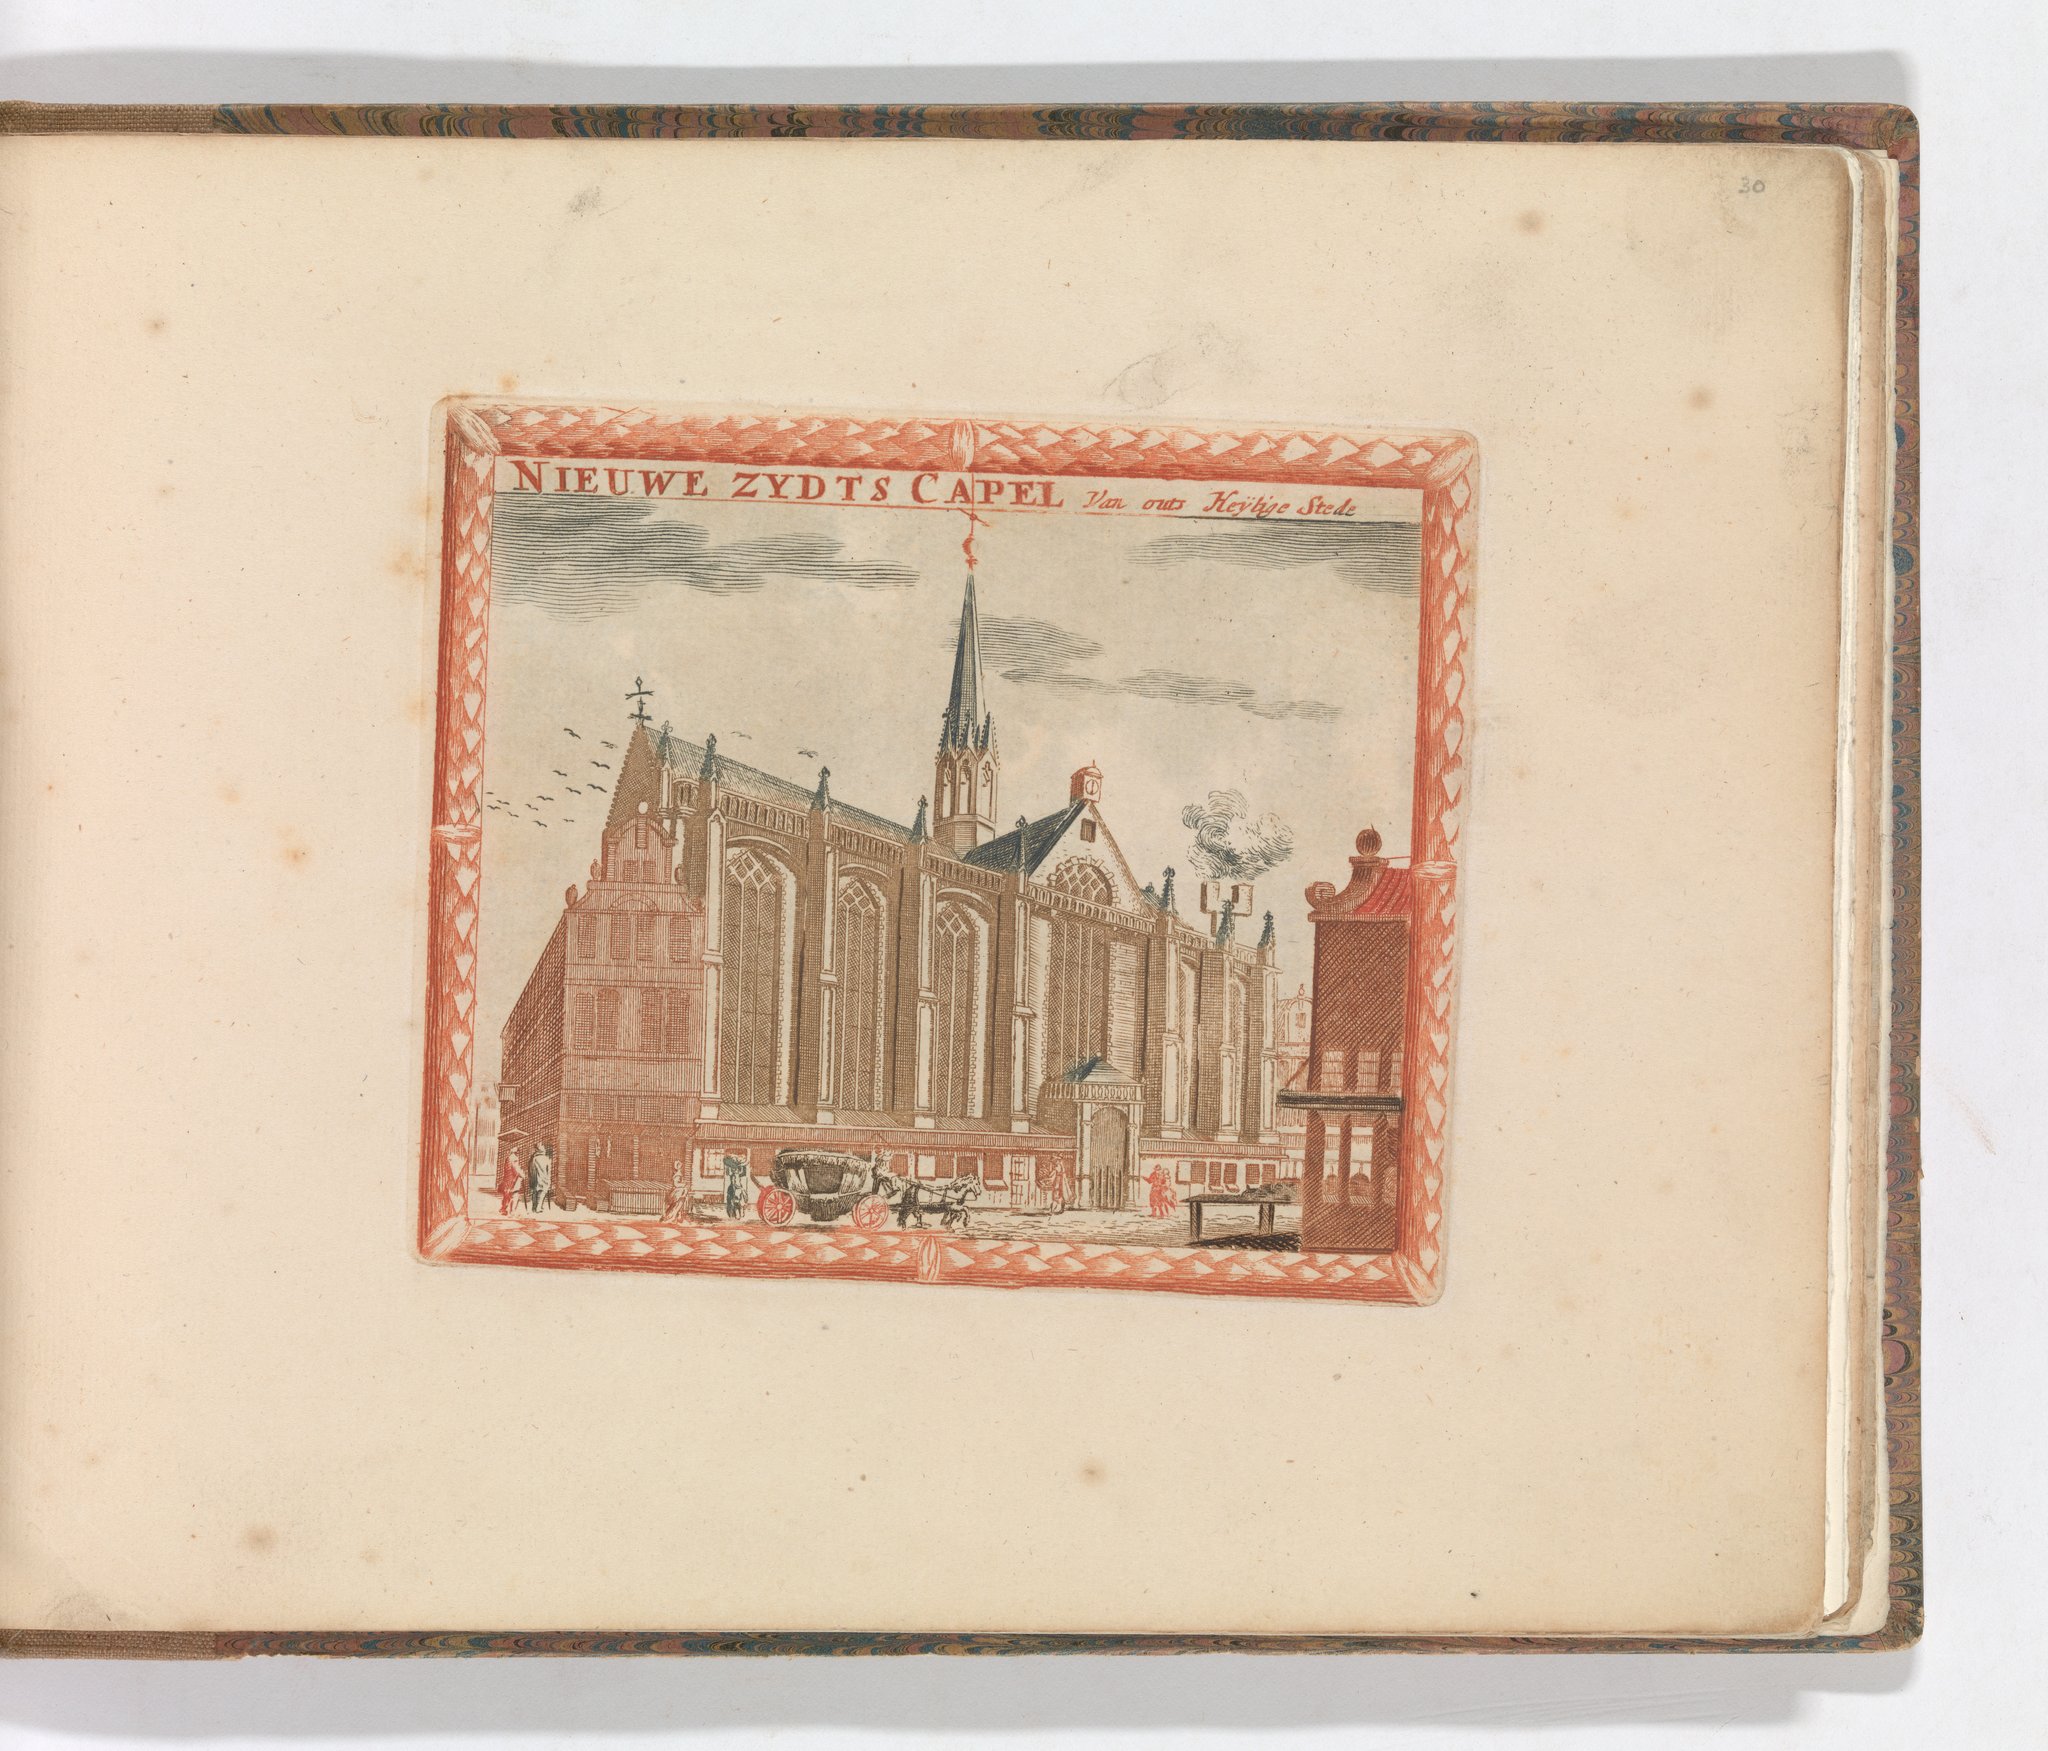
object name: book print ornament architecture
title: 'Nieuwe Zydts Capel', in: Tooneel Der Voornaamste Nederlands Huizen, En Lust Hoven, Naar T Leven Afgebeeld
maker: carel allard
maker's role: publisher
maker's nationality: dutch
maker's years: 1648-1709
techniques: engraving, lithography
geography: amsterdam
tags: buildings